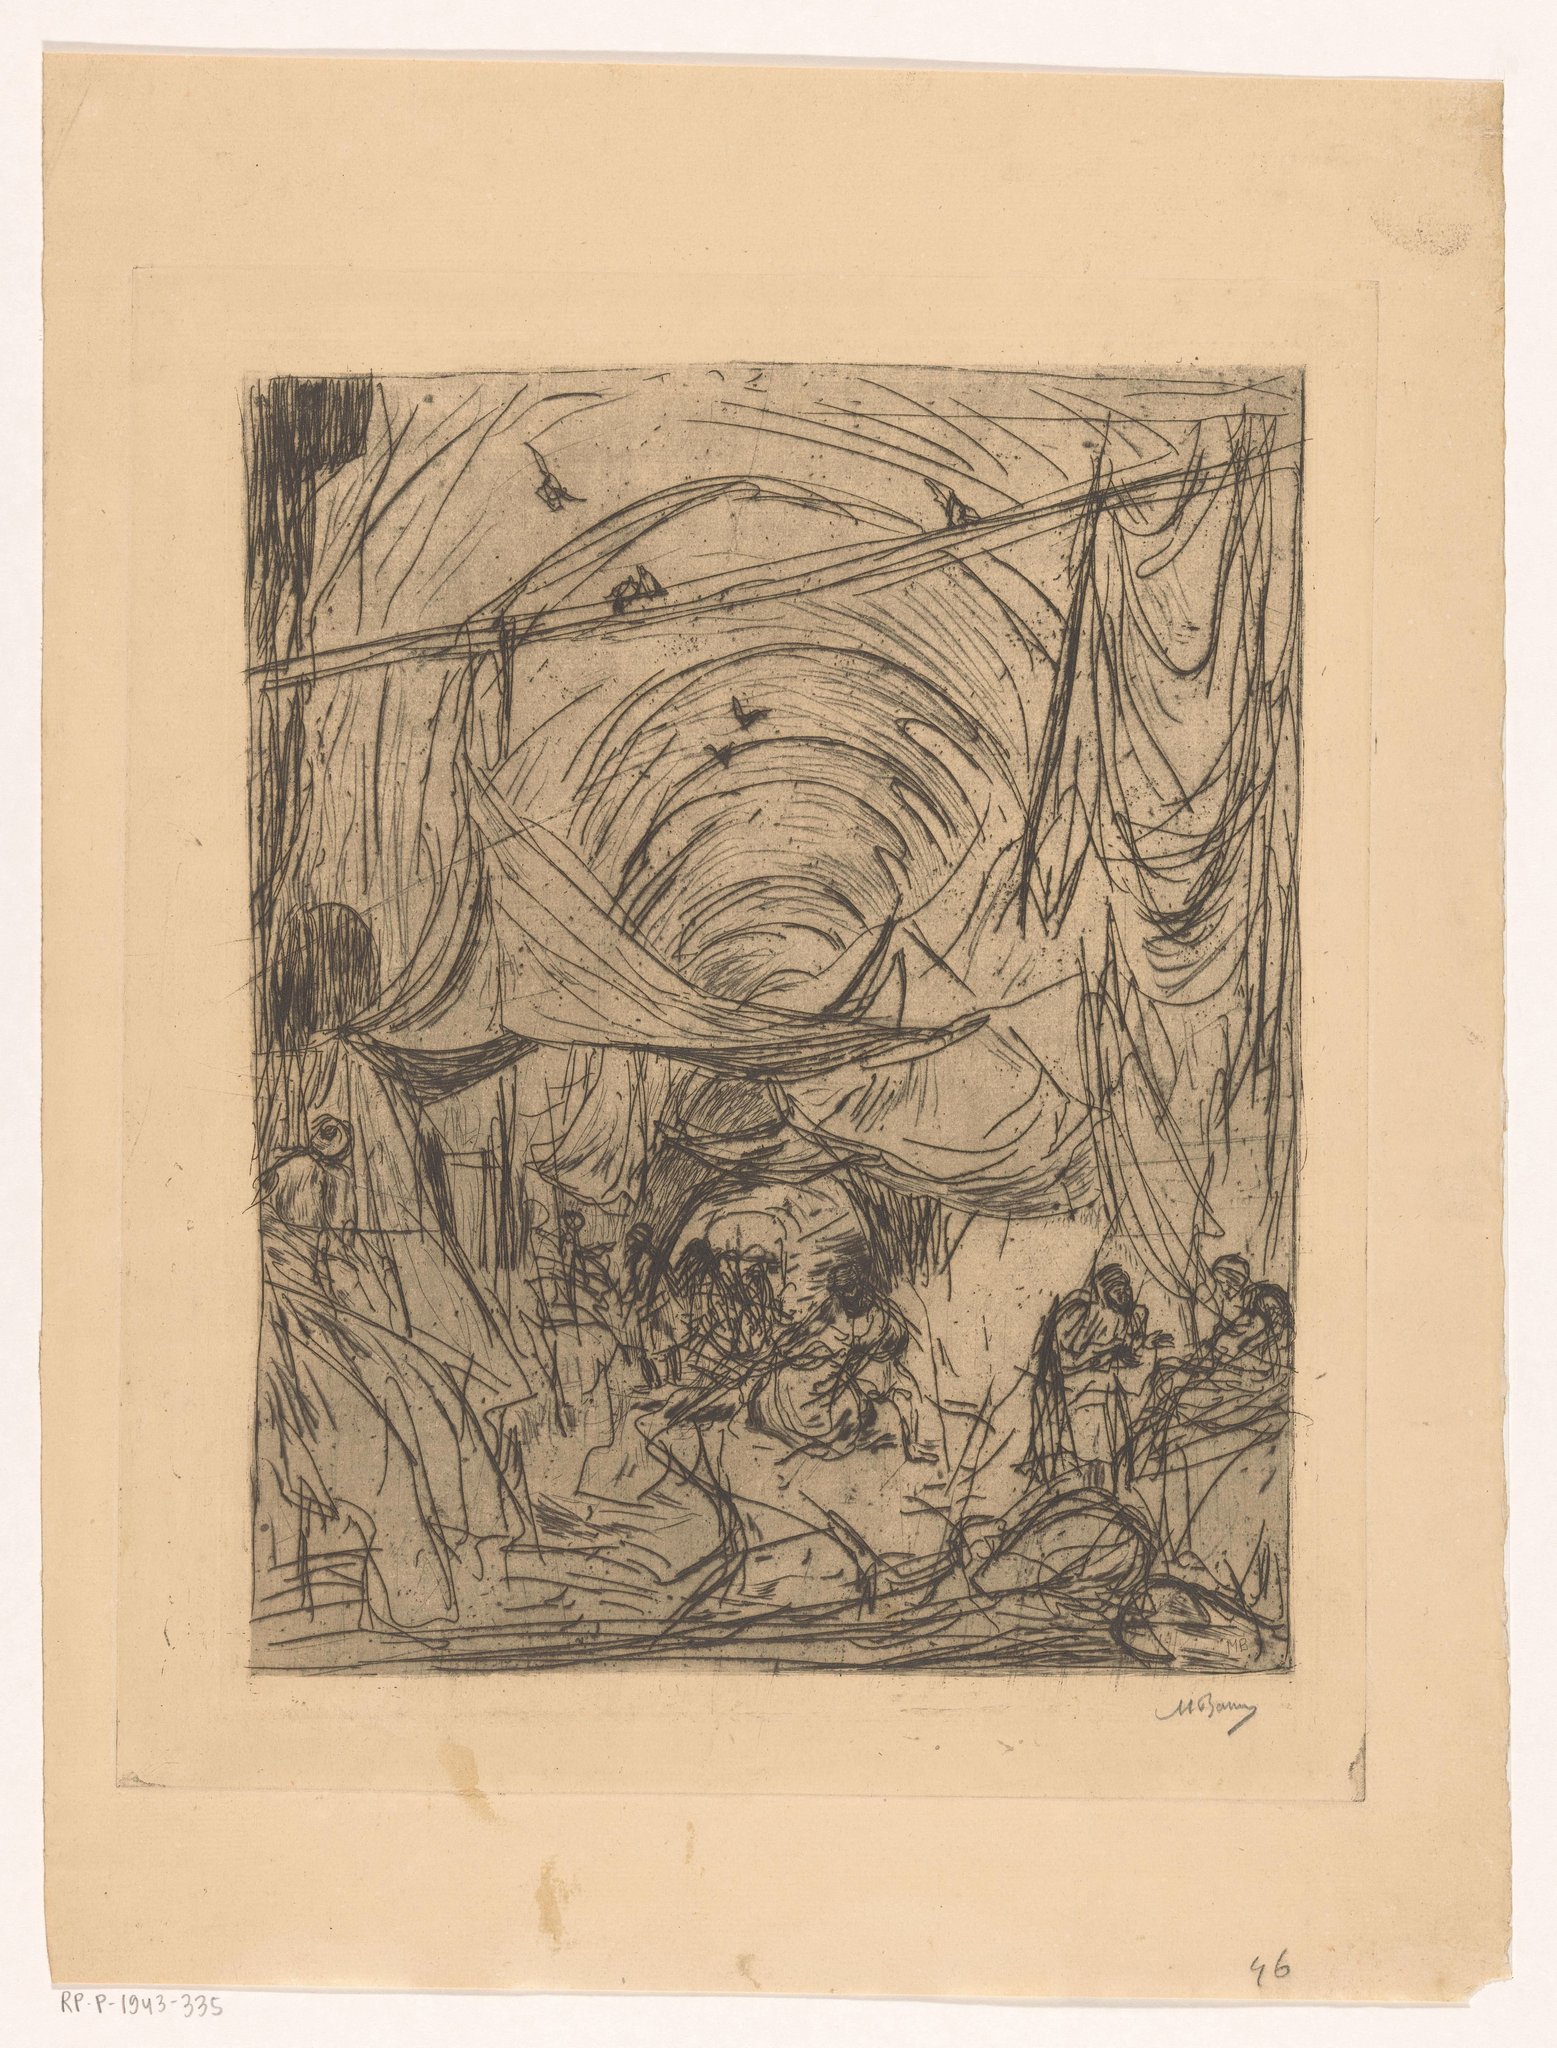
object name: print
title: Kooplieden in een bazaar in Constantinopel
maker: marius bauer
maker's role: draughtsman, print maker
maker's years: 1867-1932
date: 1888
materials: paper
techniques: etching, intaglio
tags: market-hall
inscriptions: collector's mark: Lugt 2228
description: Een overdekte bazaar met figuren in het gangpad en aan weerszijden daarvan. In het gewelf zijn doeken gespannen.